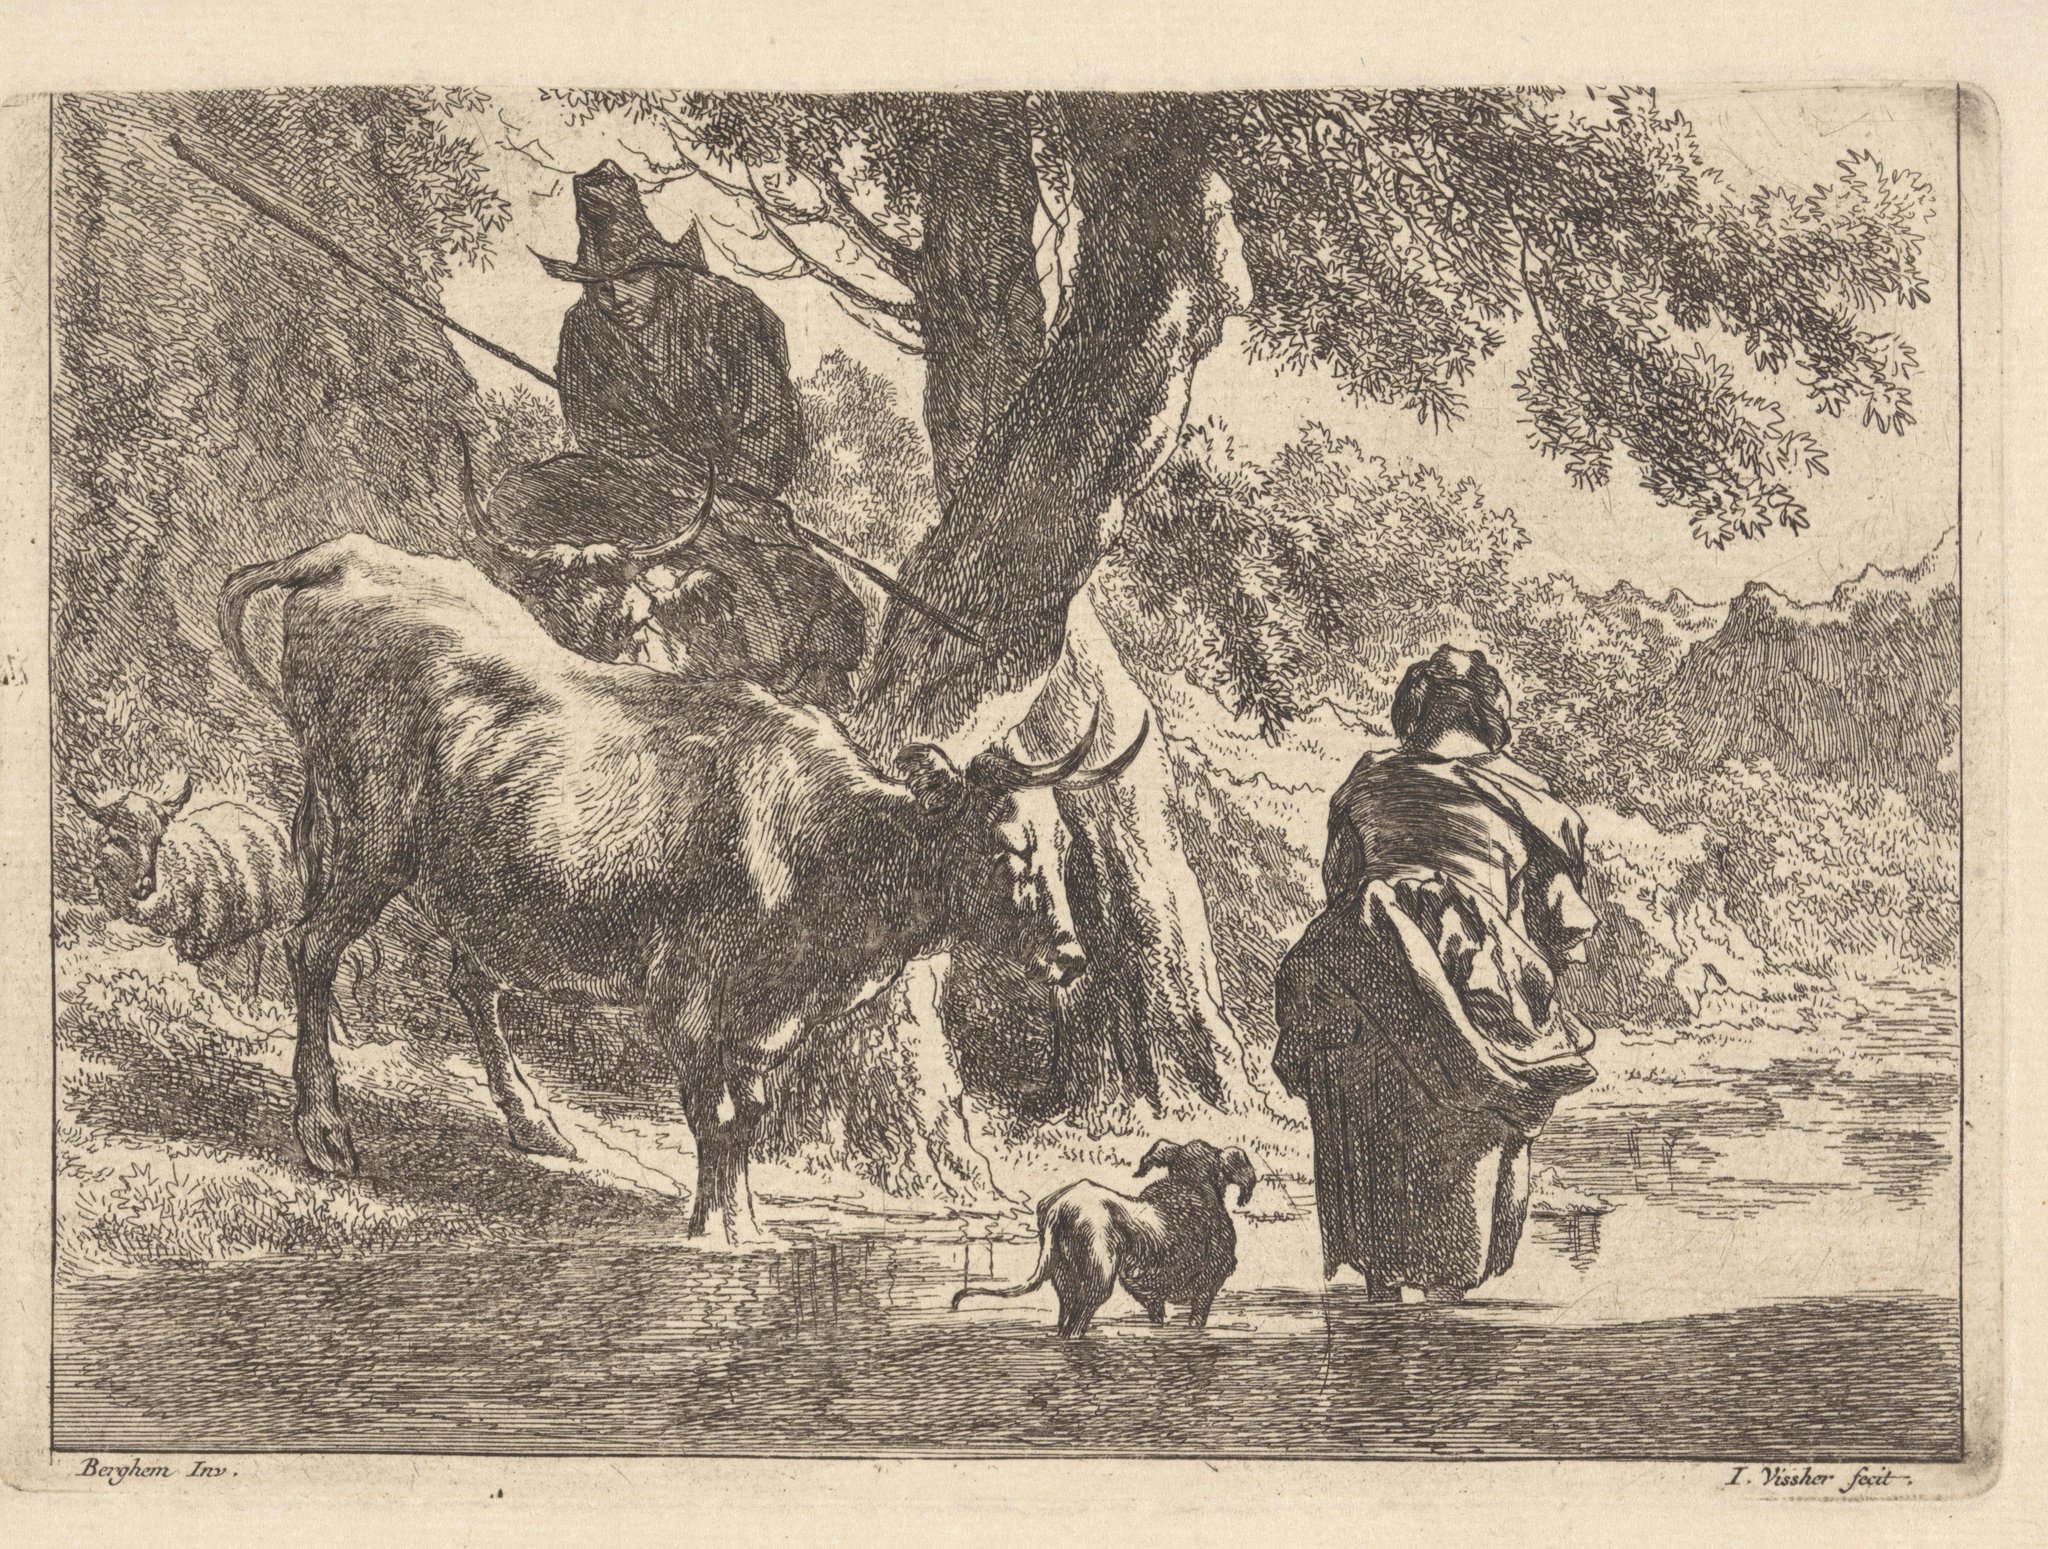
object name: print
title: Herders bij een voorde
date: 1643-1692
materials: paper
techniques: etching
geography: northern netherlands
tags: crossing a river, cow, herding, herdsman, herdswoman, shepherd, shepherdess, cowherd, etc., dog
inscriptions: collector's mark: Lugt 240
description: Een herder en herderin met twee runderen en een hond bij een doorwaadbare plaats.